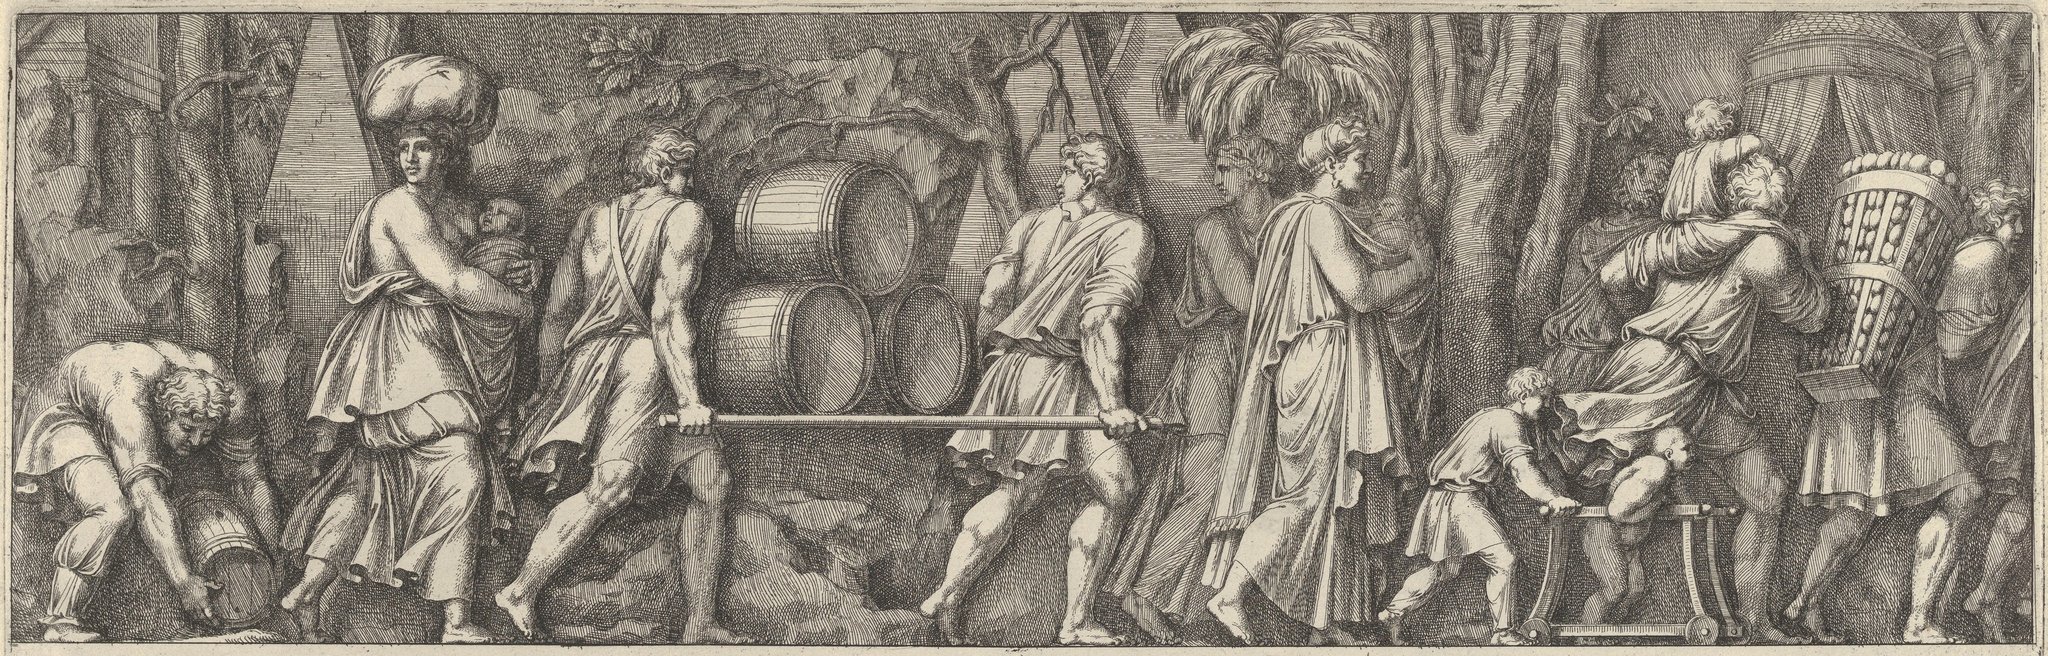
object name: print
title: Plate 3: various figures transporting materials, walking to the right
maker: pietro santi bartoli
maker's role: artist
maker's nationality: italian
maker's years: 1615-1700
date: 1660-1690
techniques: etching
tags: infants,men,women,walking